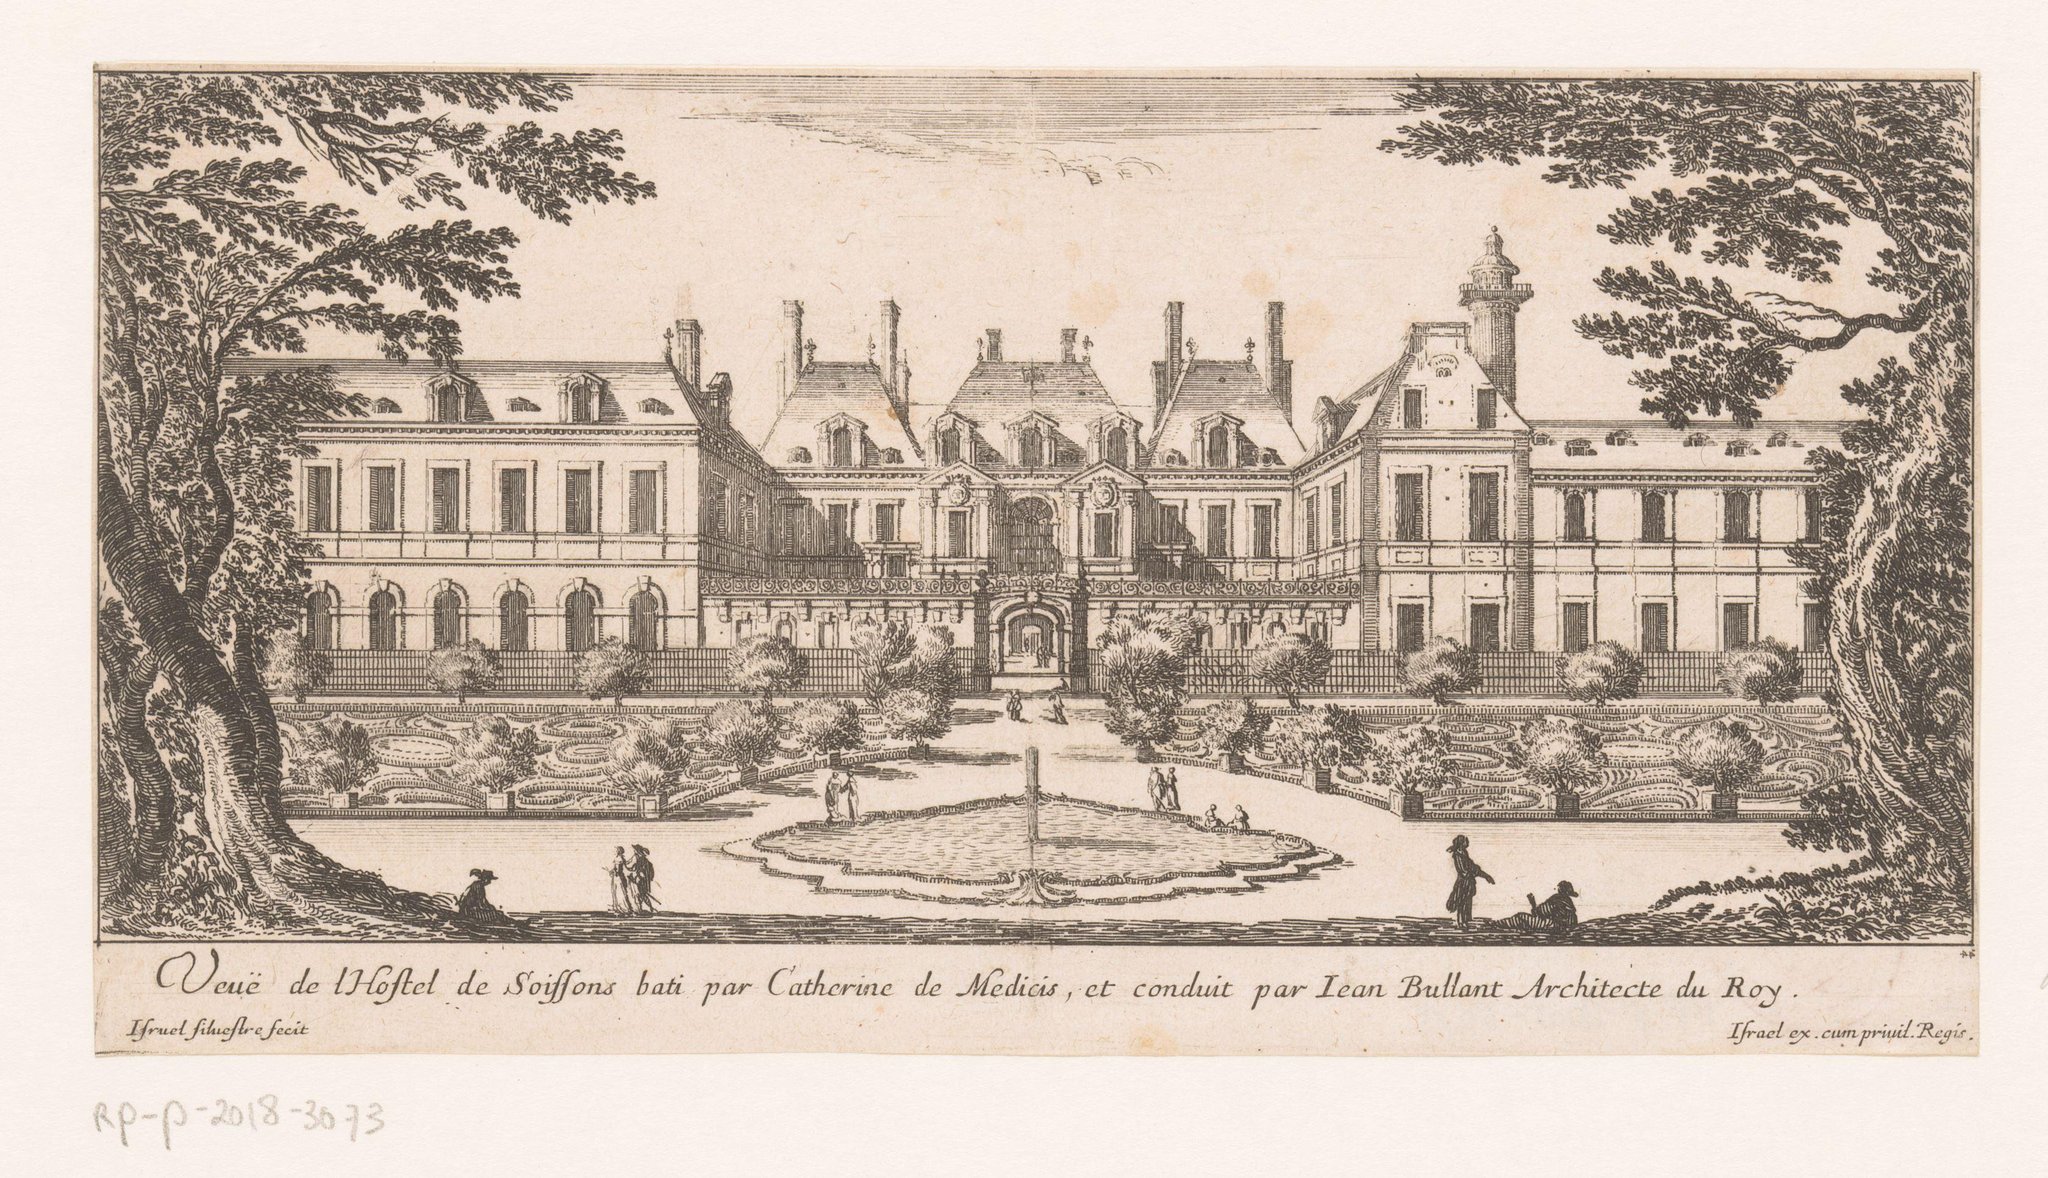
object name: print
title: Veuë de lHostel de Soissons bati par Catherine de Medicis, et conduit par Iean Bullant Architecte du Roy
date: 1650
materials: paper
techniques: etching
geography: france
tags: french or architectonic garden; formal garden, landscape with tower or castle, hôtel, i.e. small palace in city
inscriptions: collector's mark: Lugt 240, collector's mark: Lugt 2228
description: Prent maakt deel uit van een ongenummerde serie van zestien prenten.